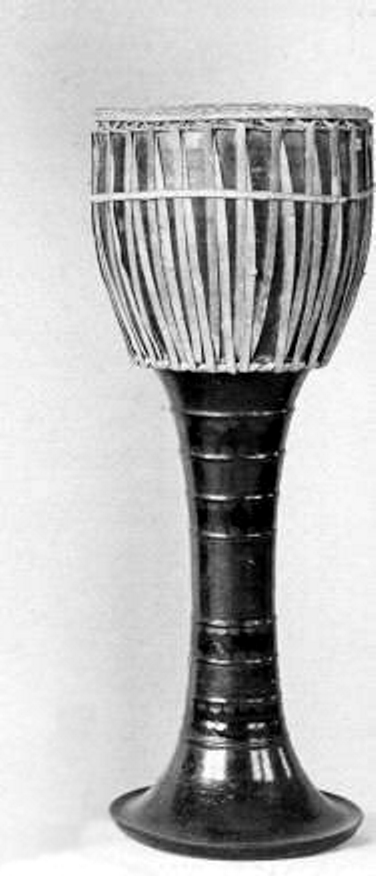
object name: ozi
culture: burmese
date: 1867-1900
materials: skin, wood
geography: myanmar